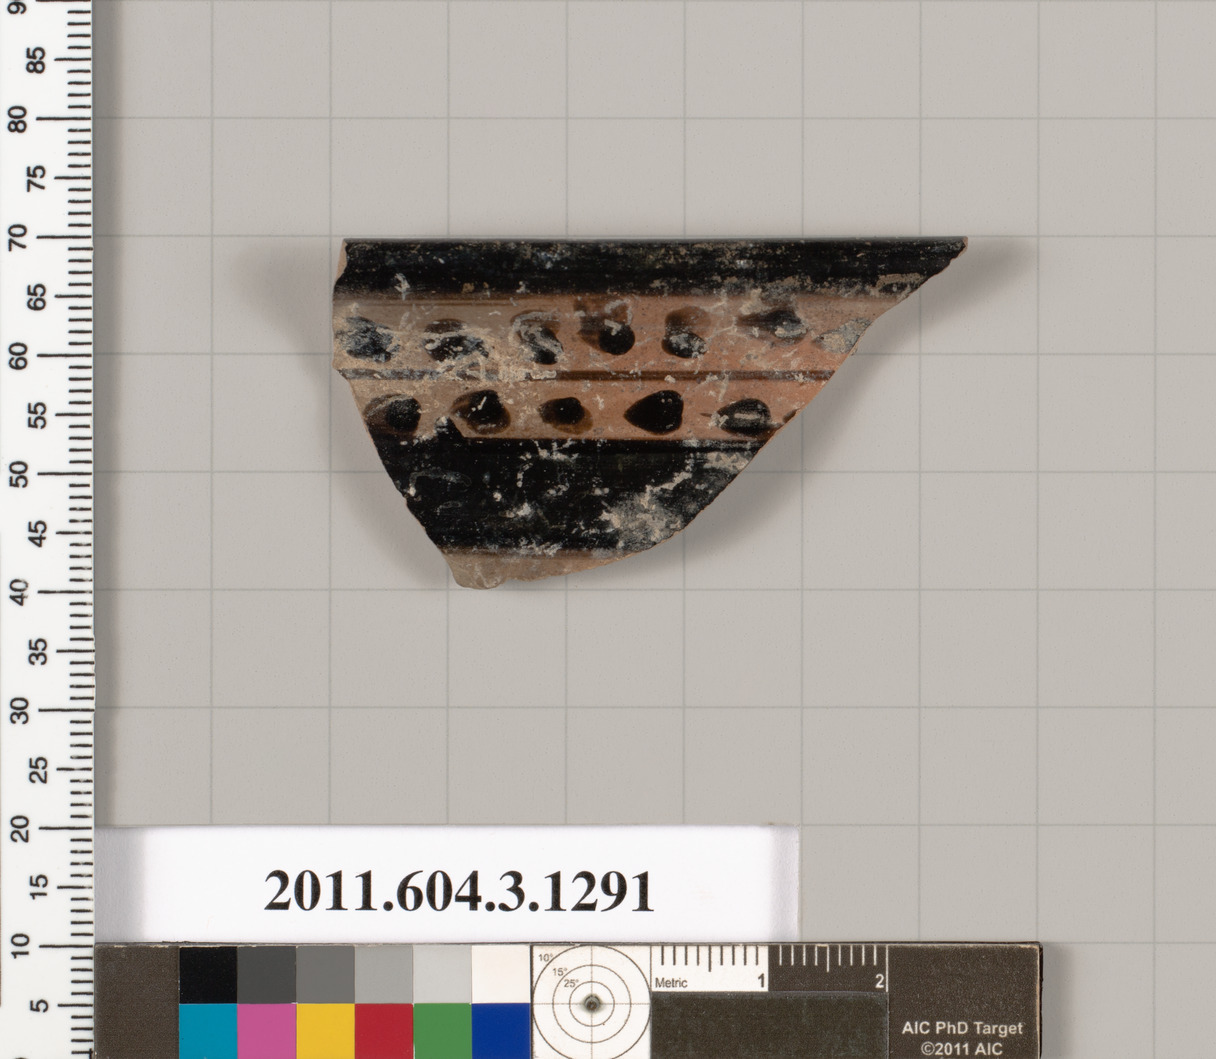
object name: skyphos fragment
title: Terracotta rim fragment of a skyphos (deep drinking cup)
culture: greek, attic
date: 500 BCE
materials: terracotta